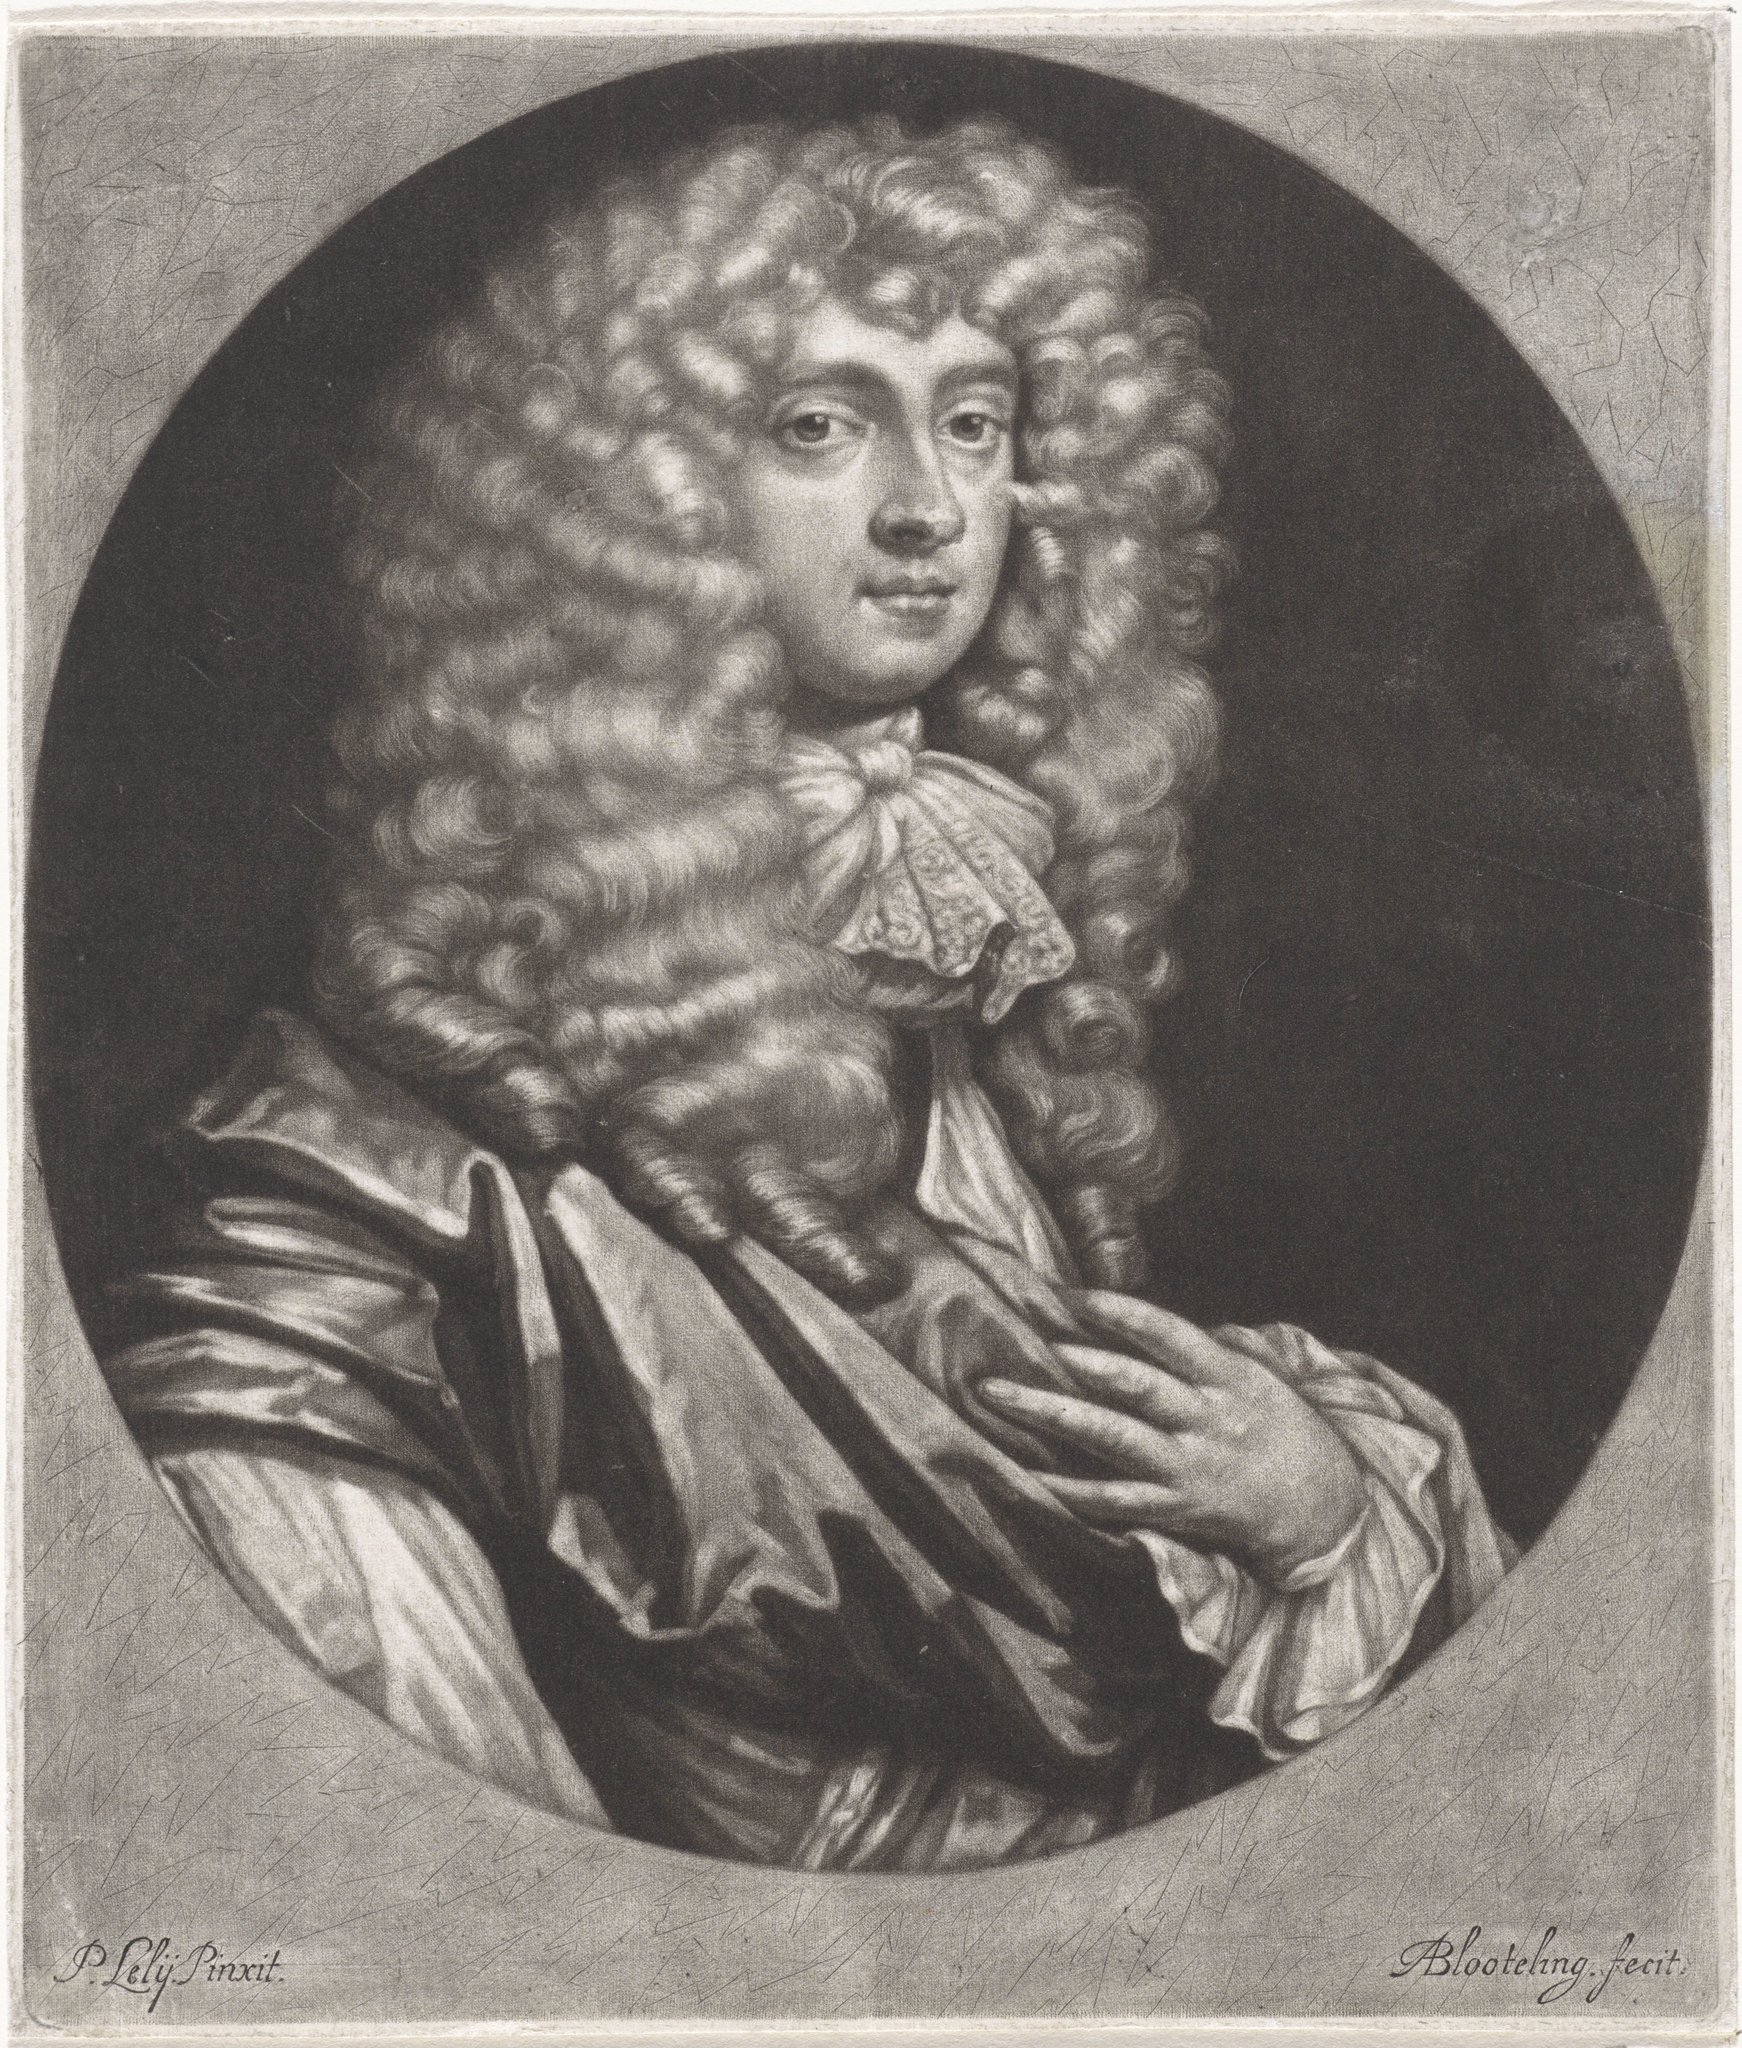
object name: print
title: Portret van Edward Montagu, tweede graaf van Sandwich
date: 1675-1679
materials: paper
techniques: mezzotint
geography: london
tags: edward montagu (2nd earl of sandwich), wig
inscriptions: collector's mark: Lugt 2228